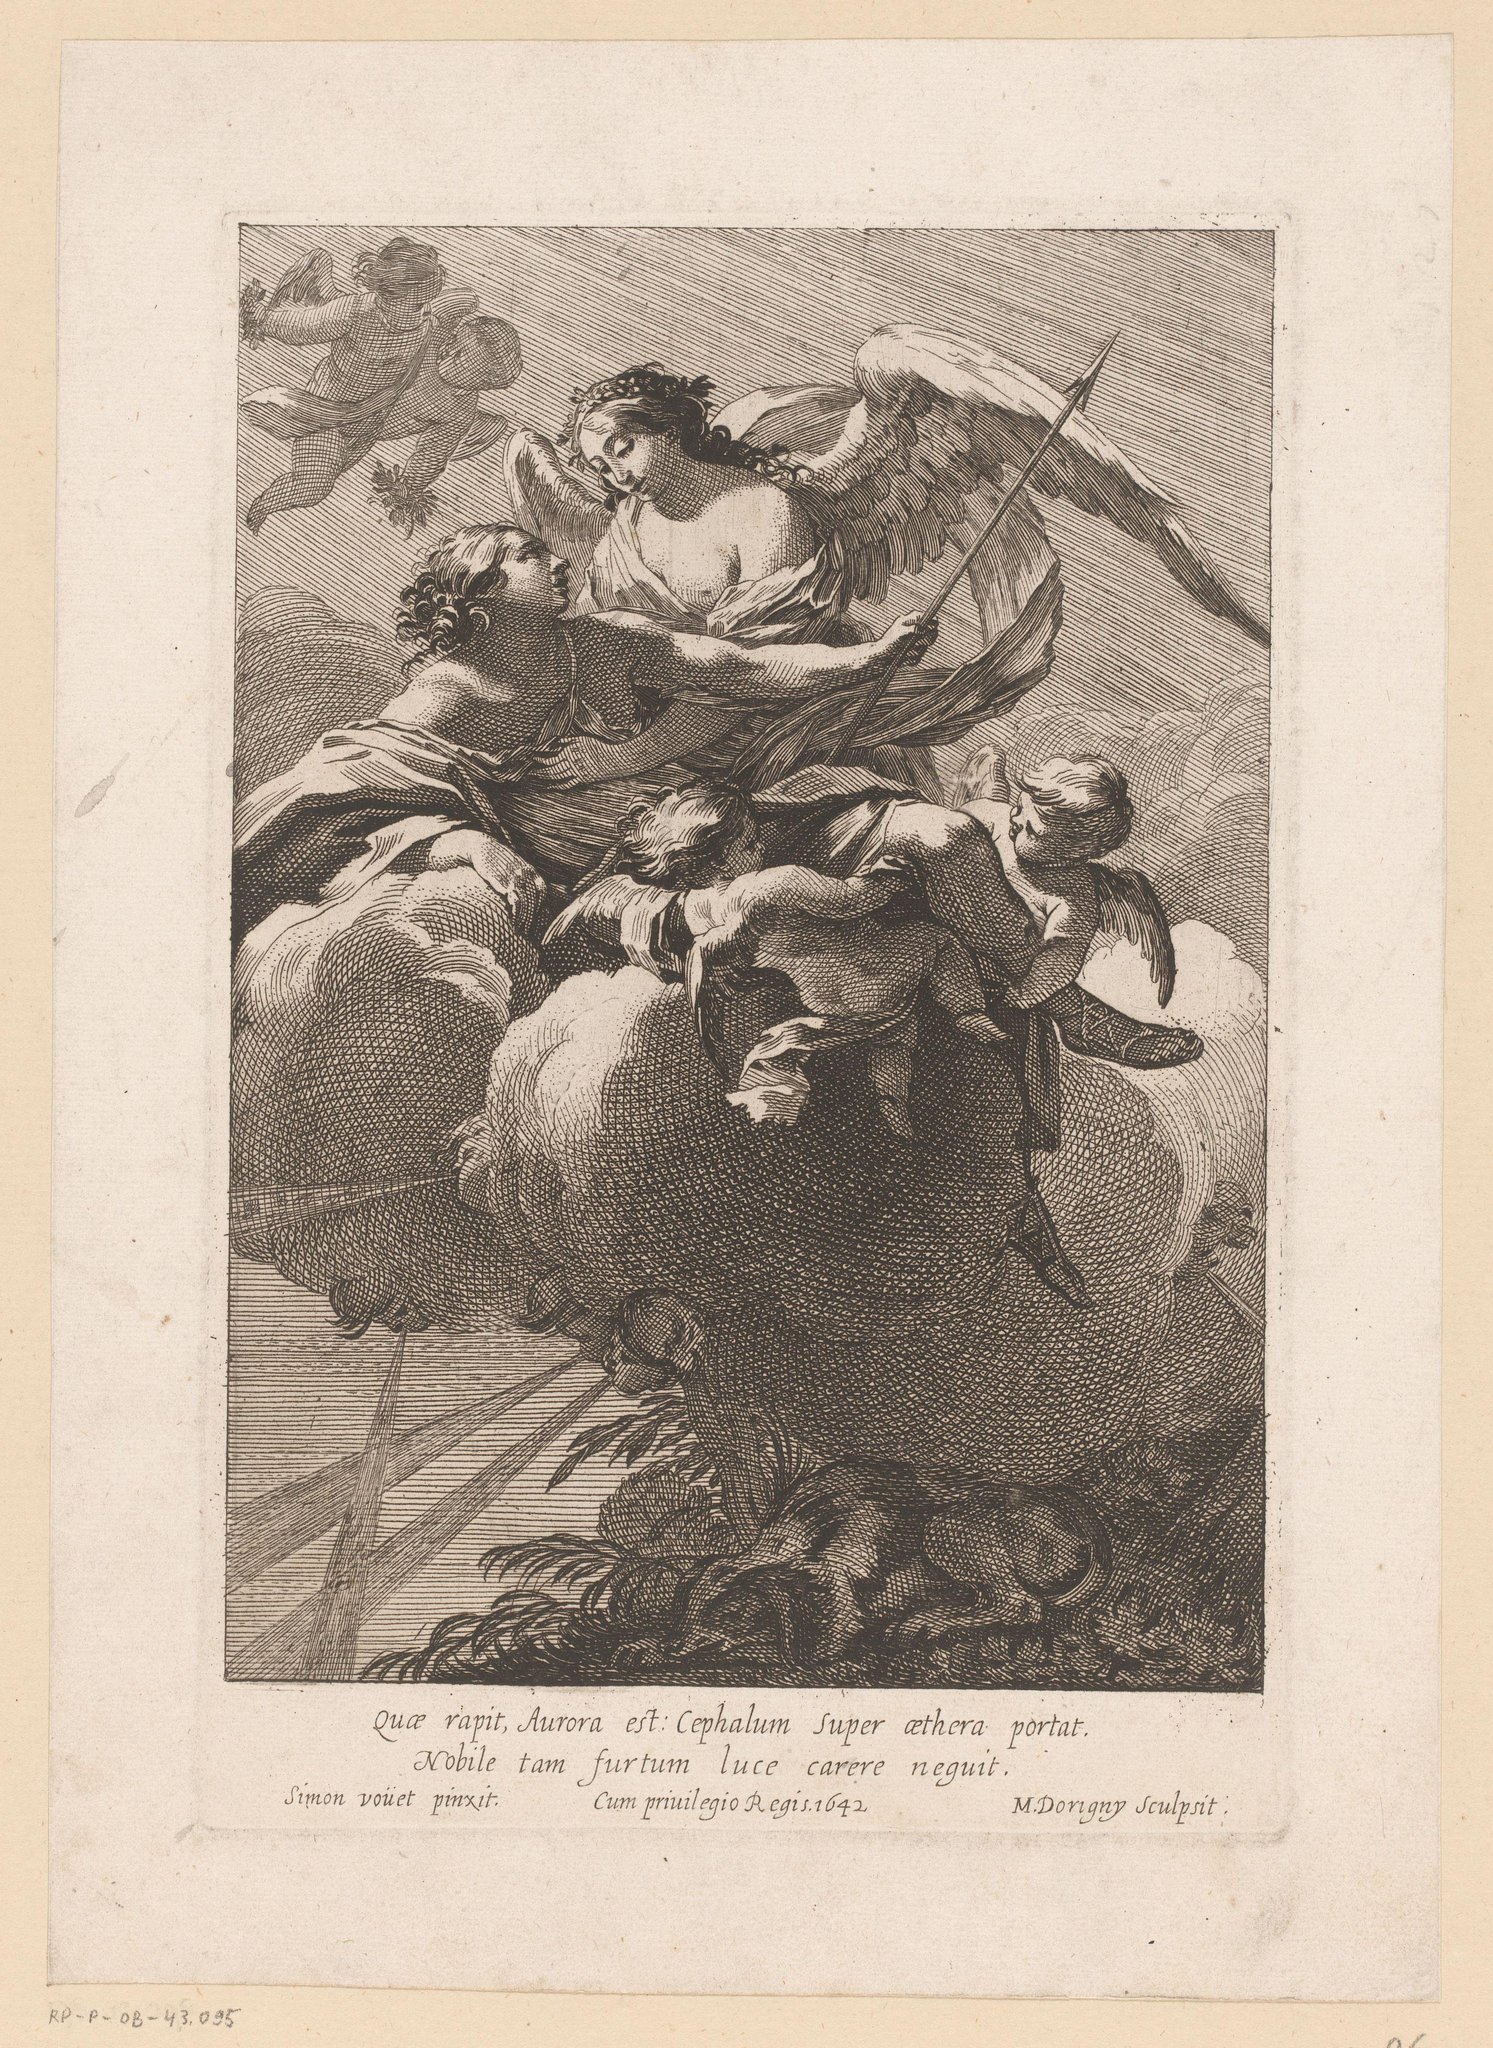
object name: print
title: Aurora en Cephalus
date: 1642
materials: paper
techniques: engraving, etching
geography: france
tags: aurora carrying off cephalus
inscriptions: collector's mark: Lugt 240